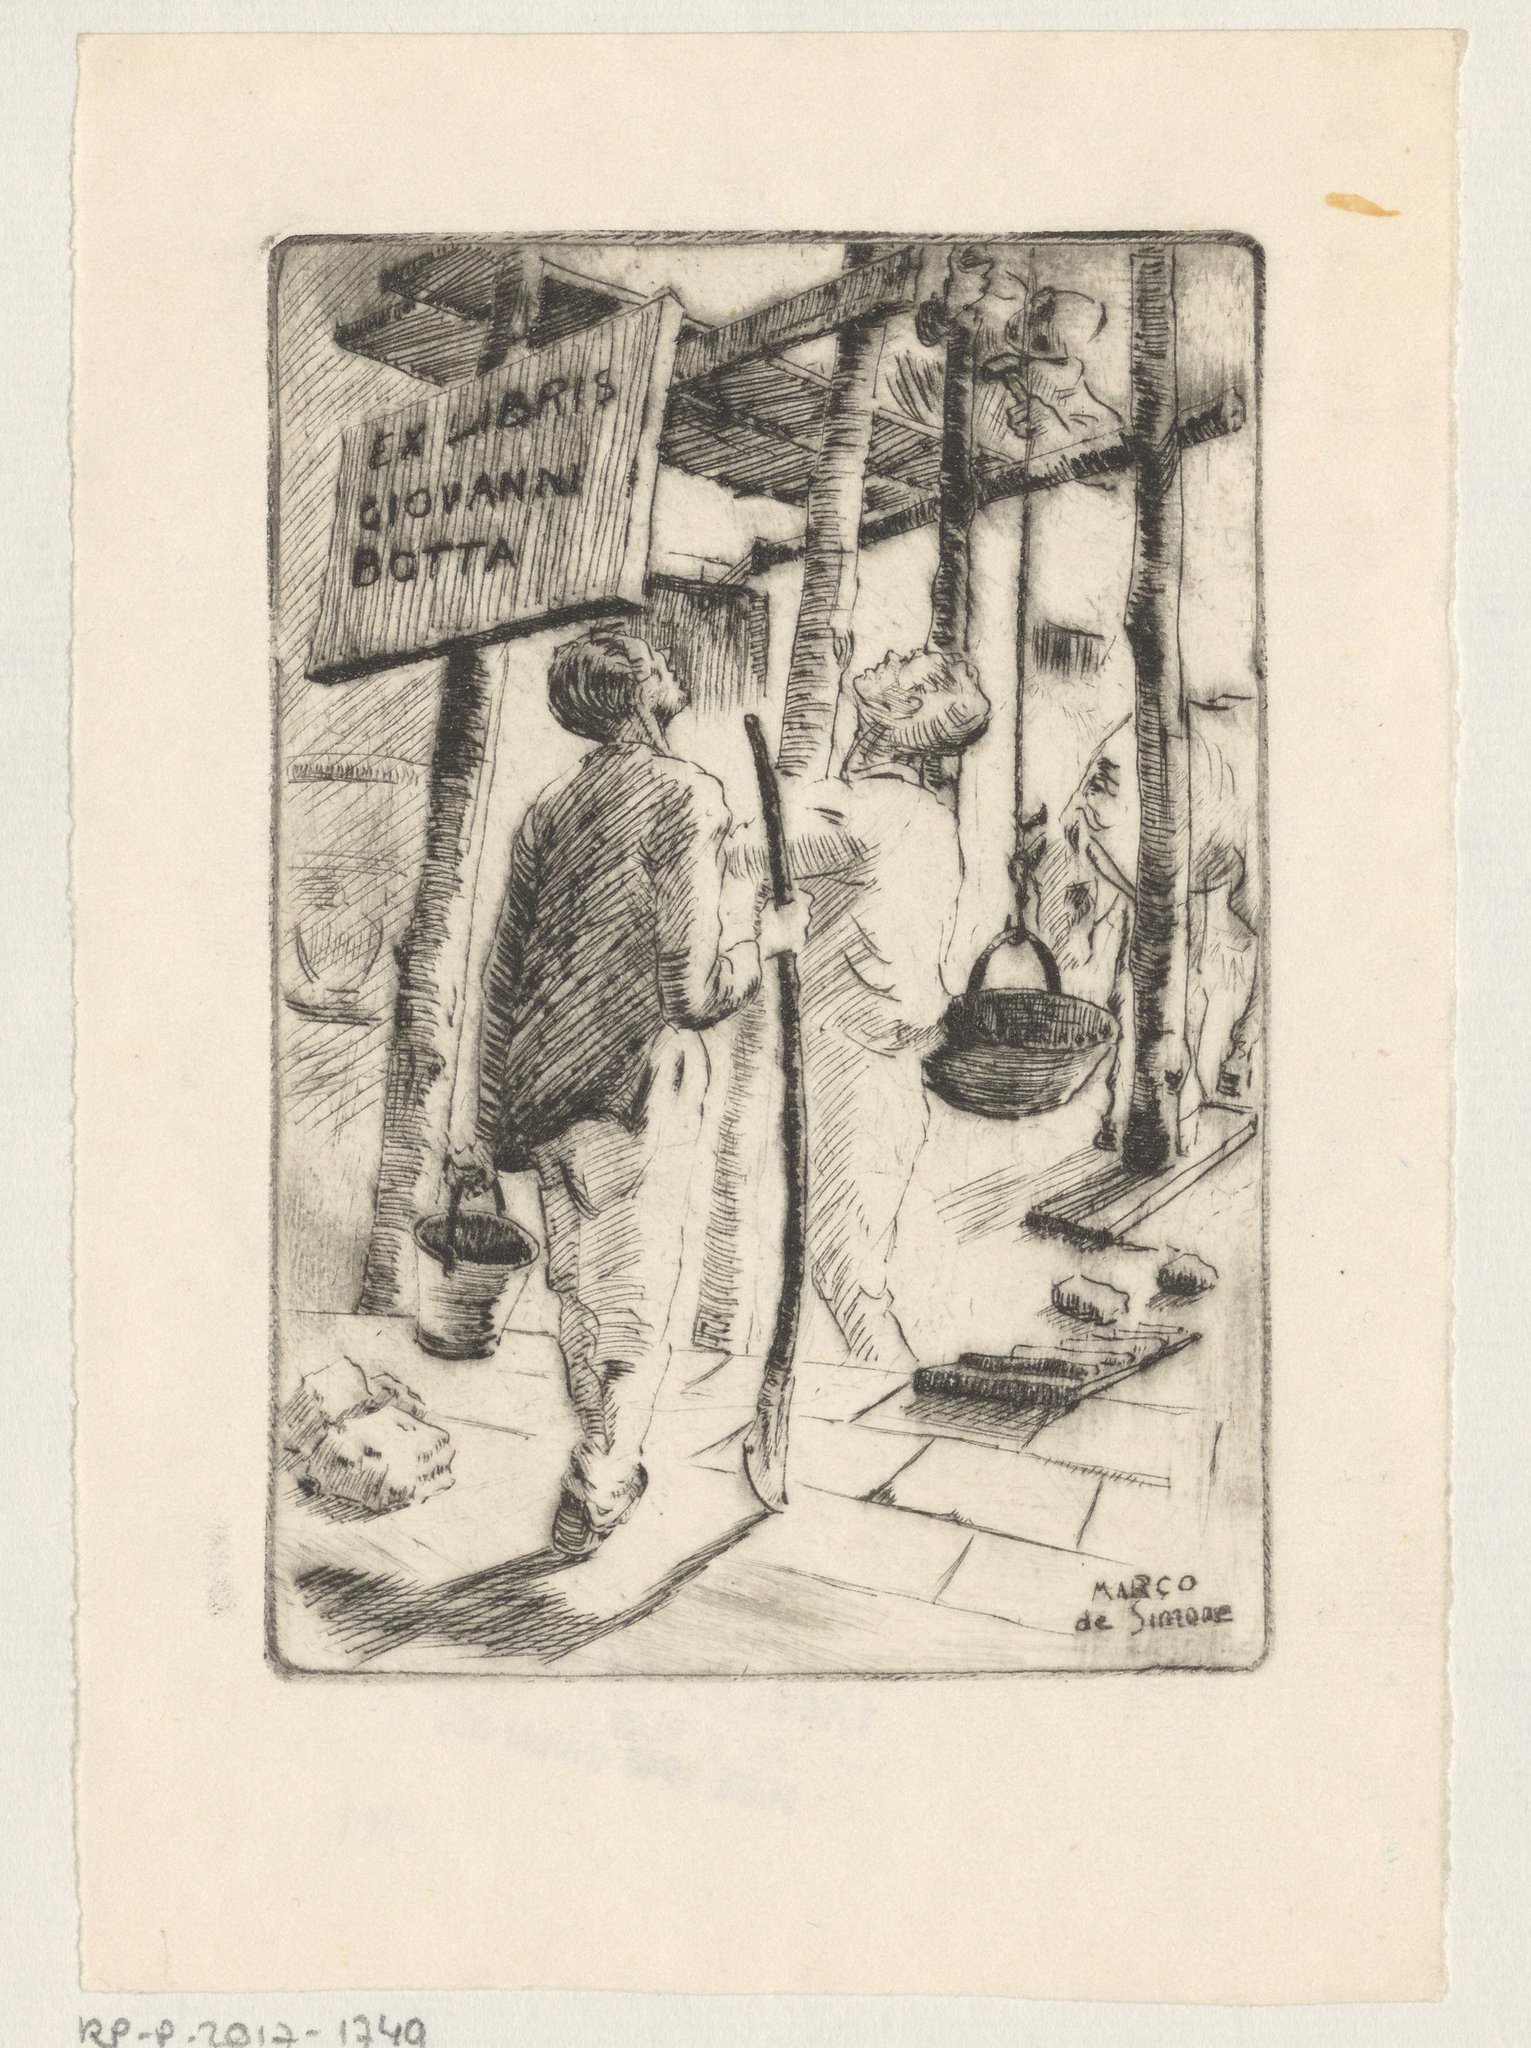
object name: bookplate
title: Ex libris van Giovanni Botta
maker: marco de simone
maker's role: print maker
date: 1948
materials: paper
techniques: etching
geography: milan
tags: politician, standing figure, scaffold (~ building activities), building-site, container of metal: bucket, can, canister, drum, tin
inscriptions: workshop stamp: ‘Marco de Simone / fece 1948 (Milano)’